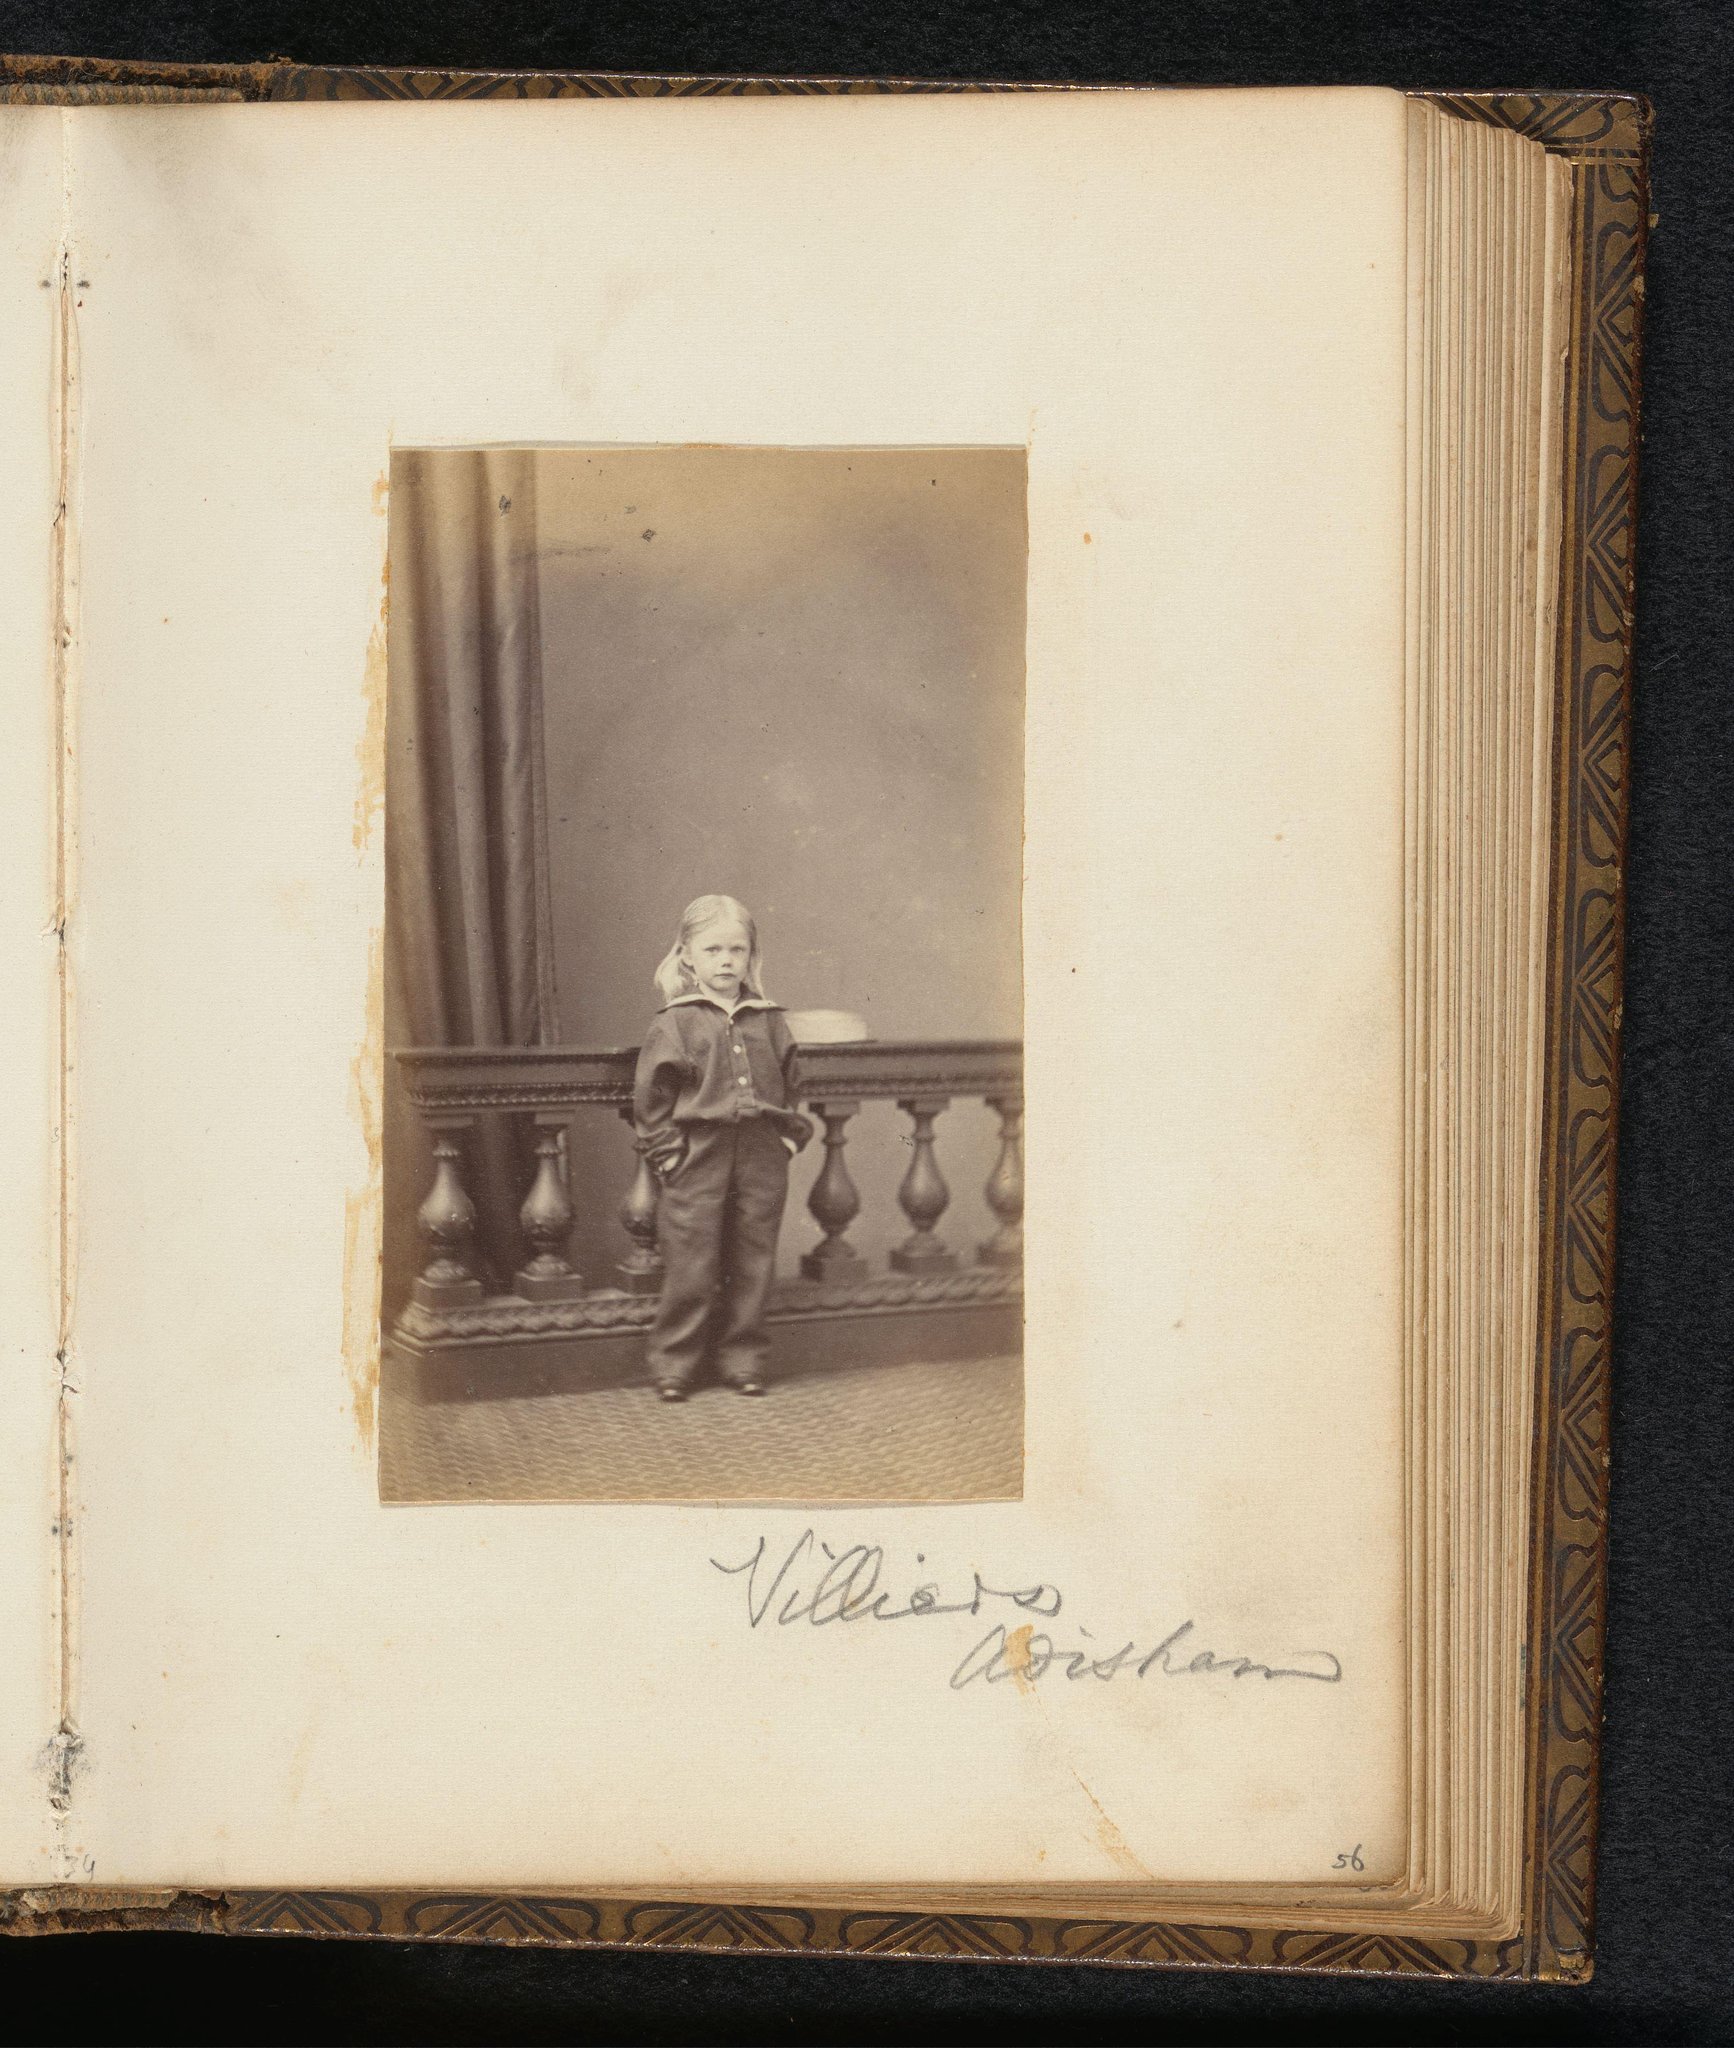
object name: photograph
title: Portret van een meisje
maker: Anonymous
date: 1865-1867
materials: cardboard, photographic support, watercolor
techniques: albumen print, aquarelle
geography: england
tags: girl (child between toddler and youth), anonymous historical person portrayed - bb - woman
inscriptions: annotation: ‘Villiers Adisham’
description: Portret van een onbekend meisje, staande voor een balustrade. Mogelijk lid van de familie Villiers, woonachtig in Adisham Hall. Foto op albumblad in album met 68 foto's merendeels met geaquarelleerde randversieringen. Het zijn voornamelijk portretten op carte-de-visite formaat.